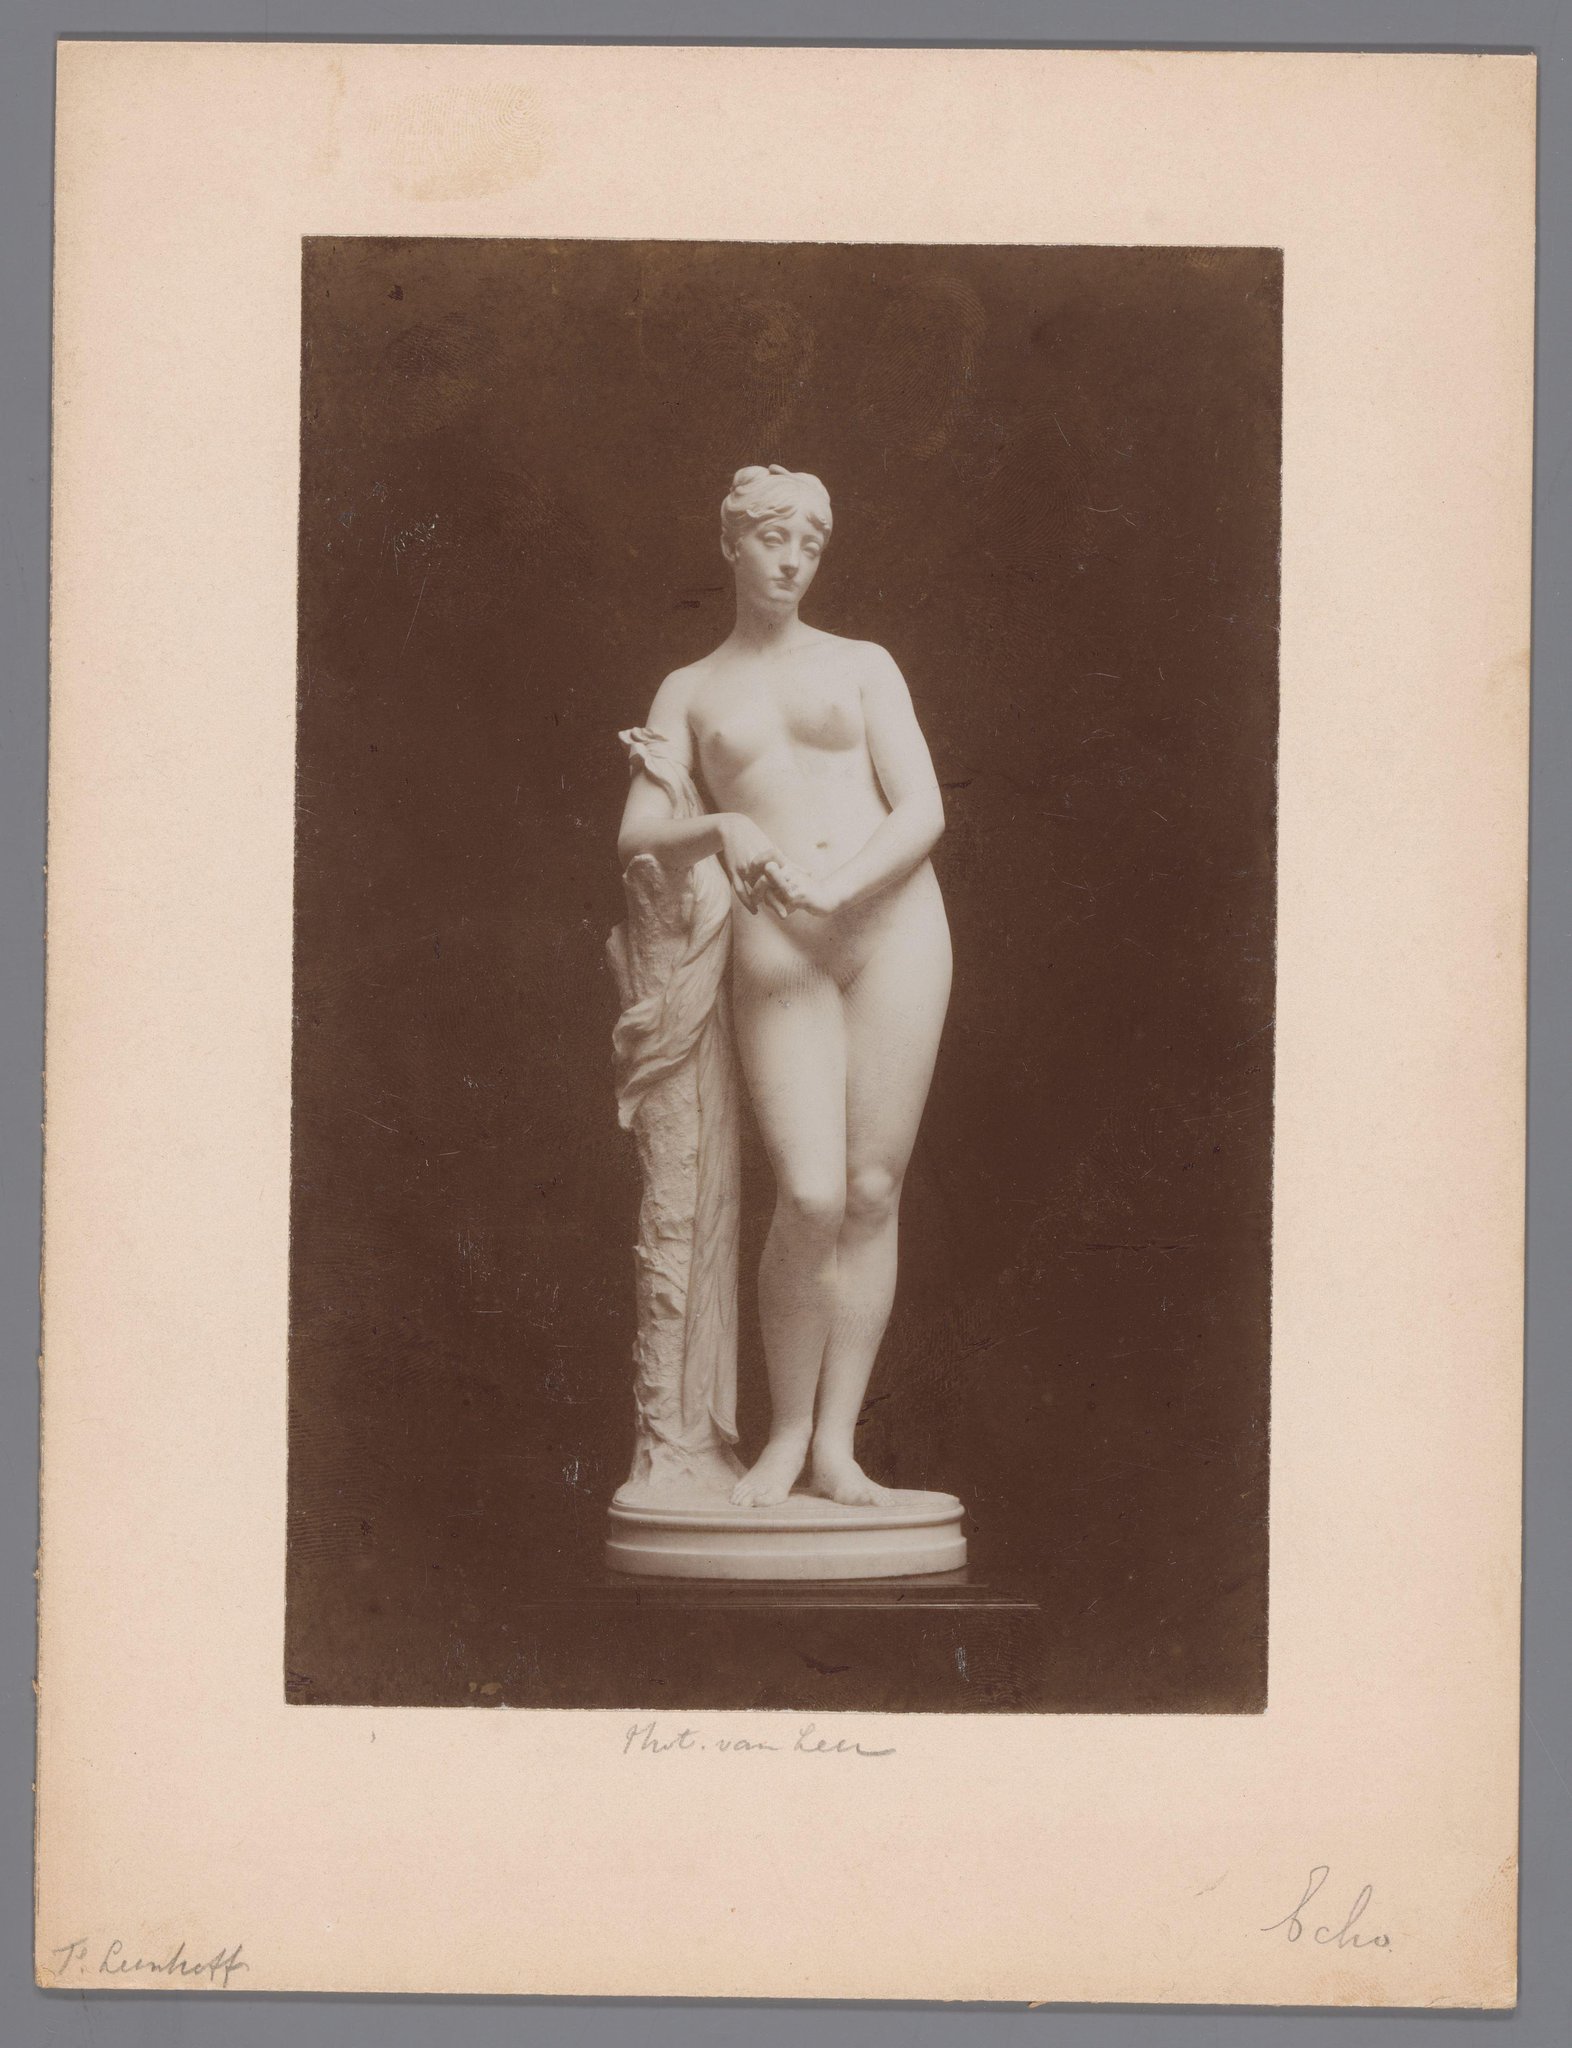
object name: photograph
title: Beeld van een vrouw of godin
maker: Anonymous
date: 1880-1940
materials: paper, cardboard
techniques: collodion silver print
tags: sculpture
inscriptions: collector's mark: Lugt 2228, inscription: ‘Phot van leer/ To Leenhoff [...]’, number: ‘AA 985’